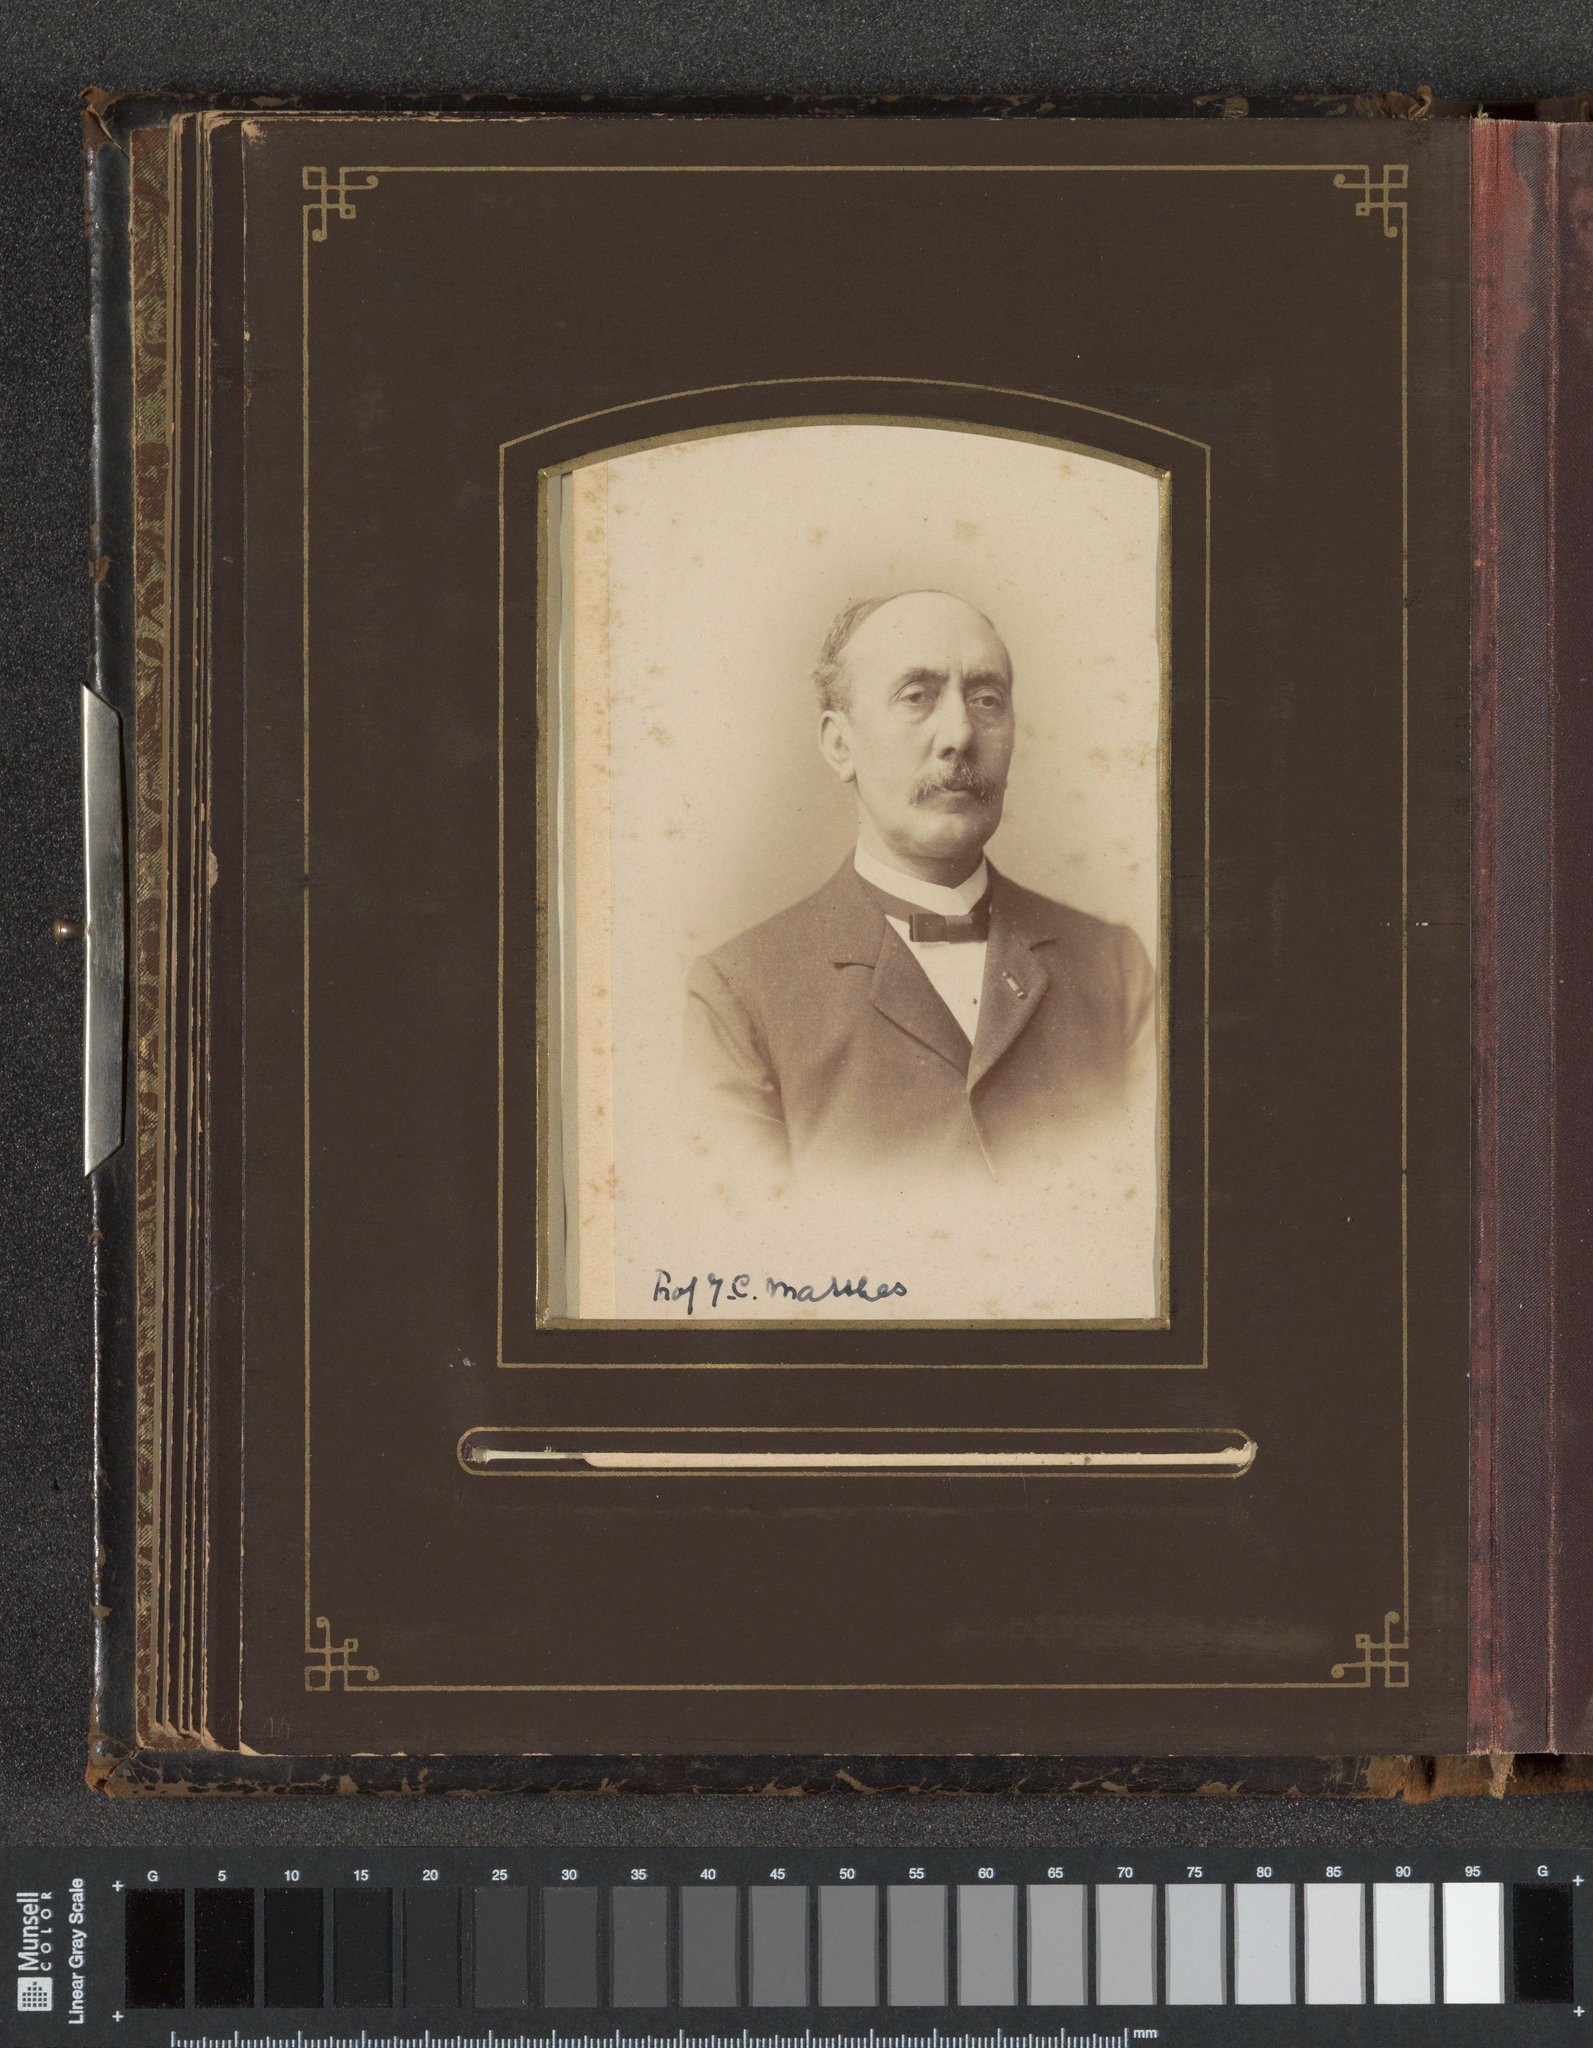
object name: photograph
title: Portret van professor J.C. Matthes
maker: albert greiner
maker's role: fotograaf, fotostudio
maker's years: 1833-1890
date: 1874-1887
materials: cardboard, paper, photographic support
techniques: albumen print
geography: amsterdam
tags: adult man, historical persons, professor, amsterdam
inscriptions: address: ‘Amsterdam Nieuwendijk 89.’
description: Onderdeel van Fotoalbum van de families Matthes, Doorman en Van Thiel.